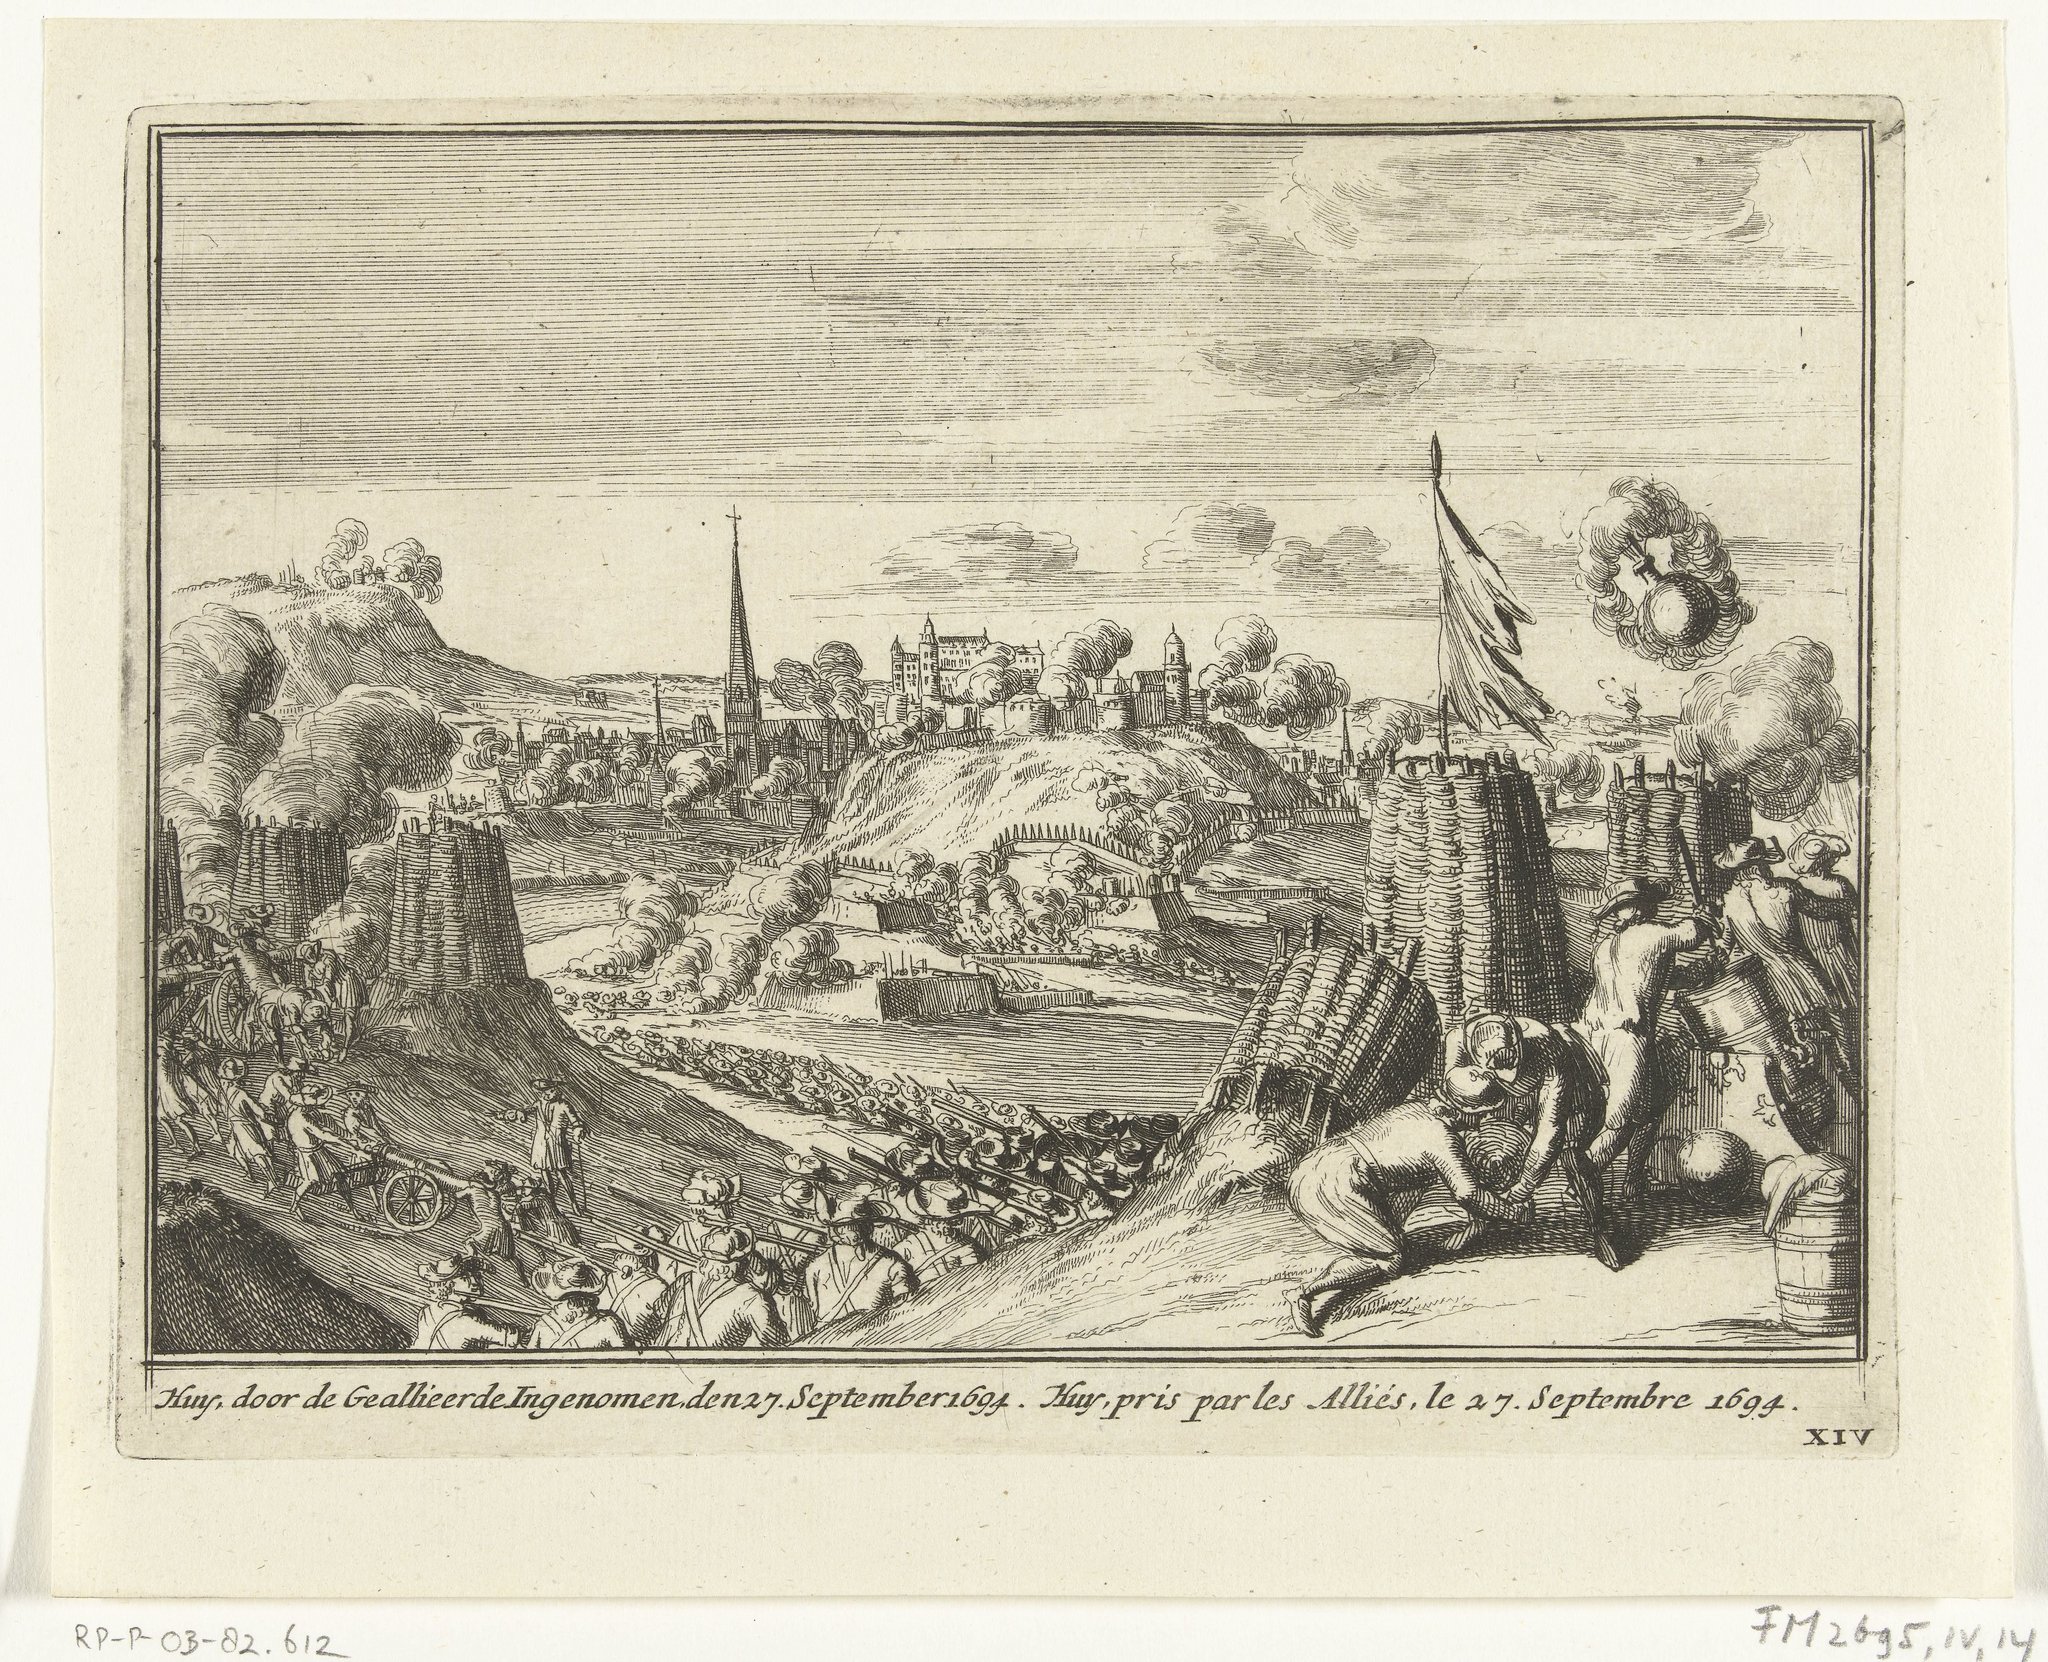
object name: print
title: Engelands Schoutoneel, verbeeldende 't Gedenckwaardigste in en ontrent Engeland, Yerland, Vrankryk en de Nederlanden voorgevallen, zedert 't Jaar 1692, tot het Begraven der Koninginne Maria de tweede, 1695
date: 1695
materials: paper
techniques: etching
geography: amsterdam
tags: capture of city (after the siege)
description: Inname van Huy door het geallieerde leger, 27 september 1694. Plaat nr. XIV in de serie 'Engelands schouwtoneel' over oorlogen gevoerd door Willem III in de jaren 1691-1695 na de Glorious Revolution, (vierde deel). Met onderschriften in het Nederlands en Frans.